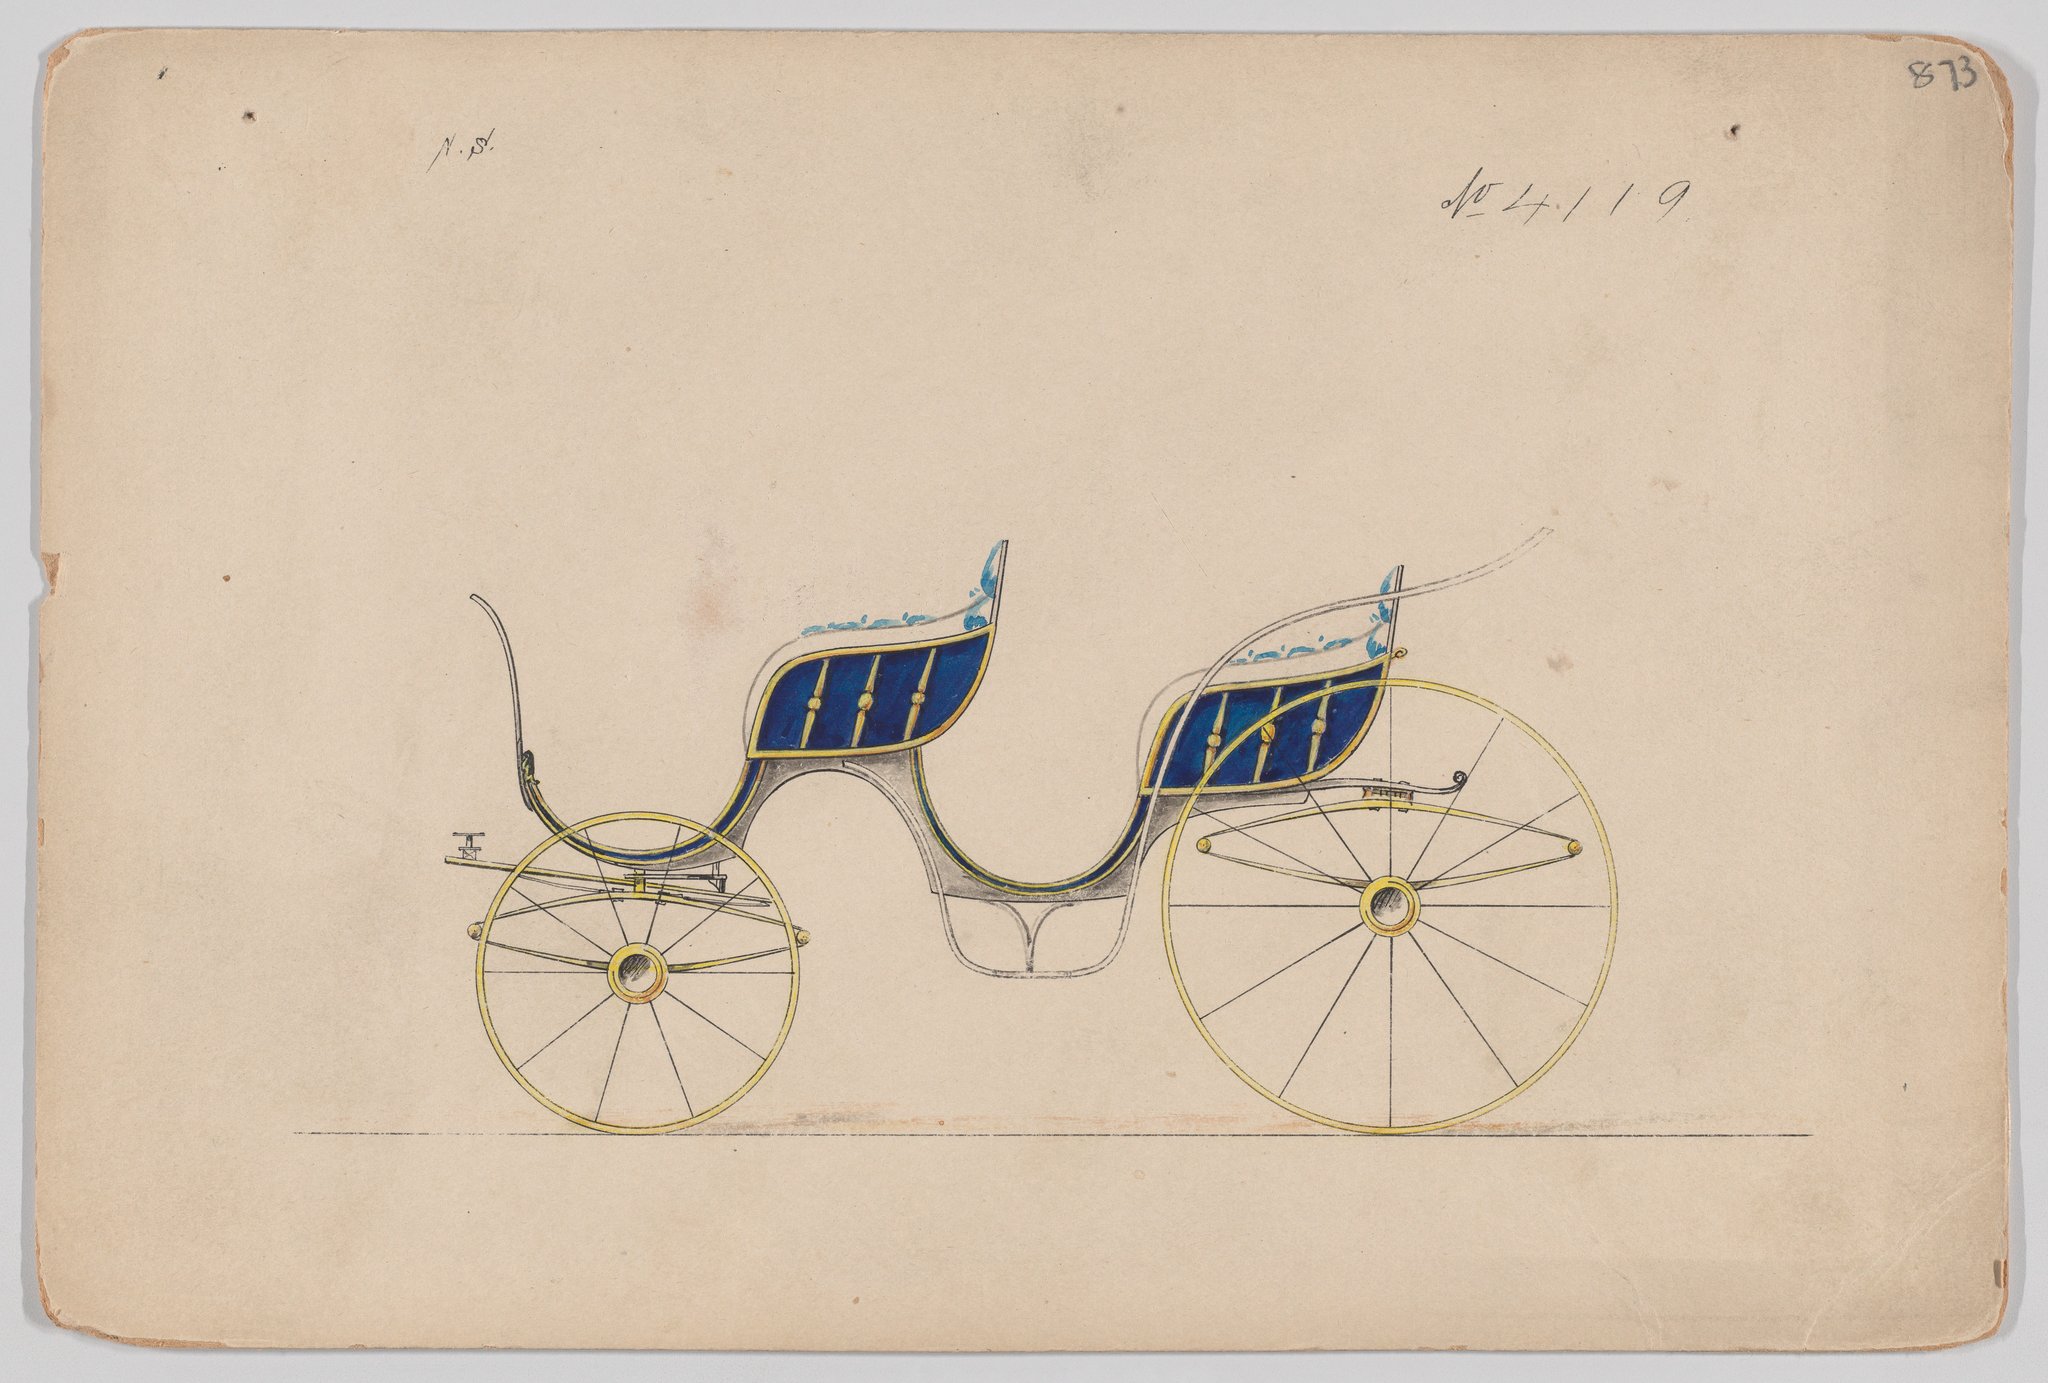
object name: drawing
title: Design for 4 seat Phaeton, no top, no. 4119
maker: brewster & co.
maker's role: manufacturer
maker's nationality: american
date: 1891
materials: gouache, ink, watercolor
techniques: pen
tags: carriages